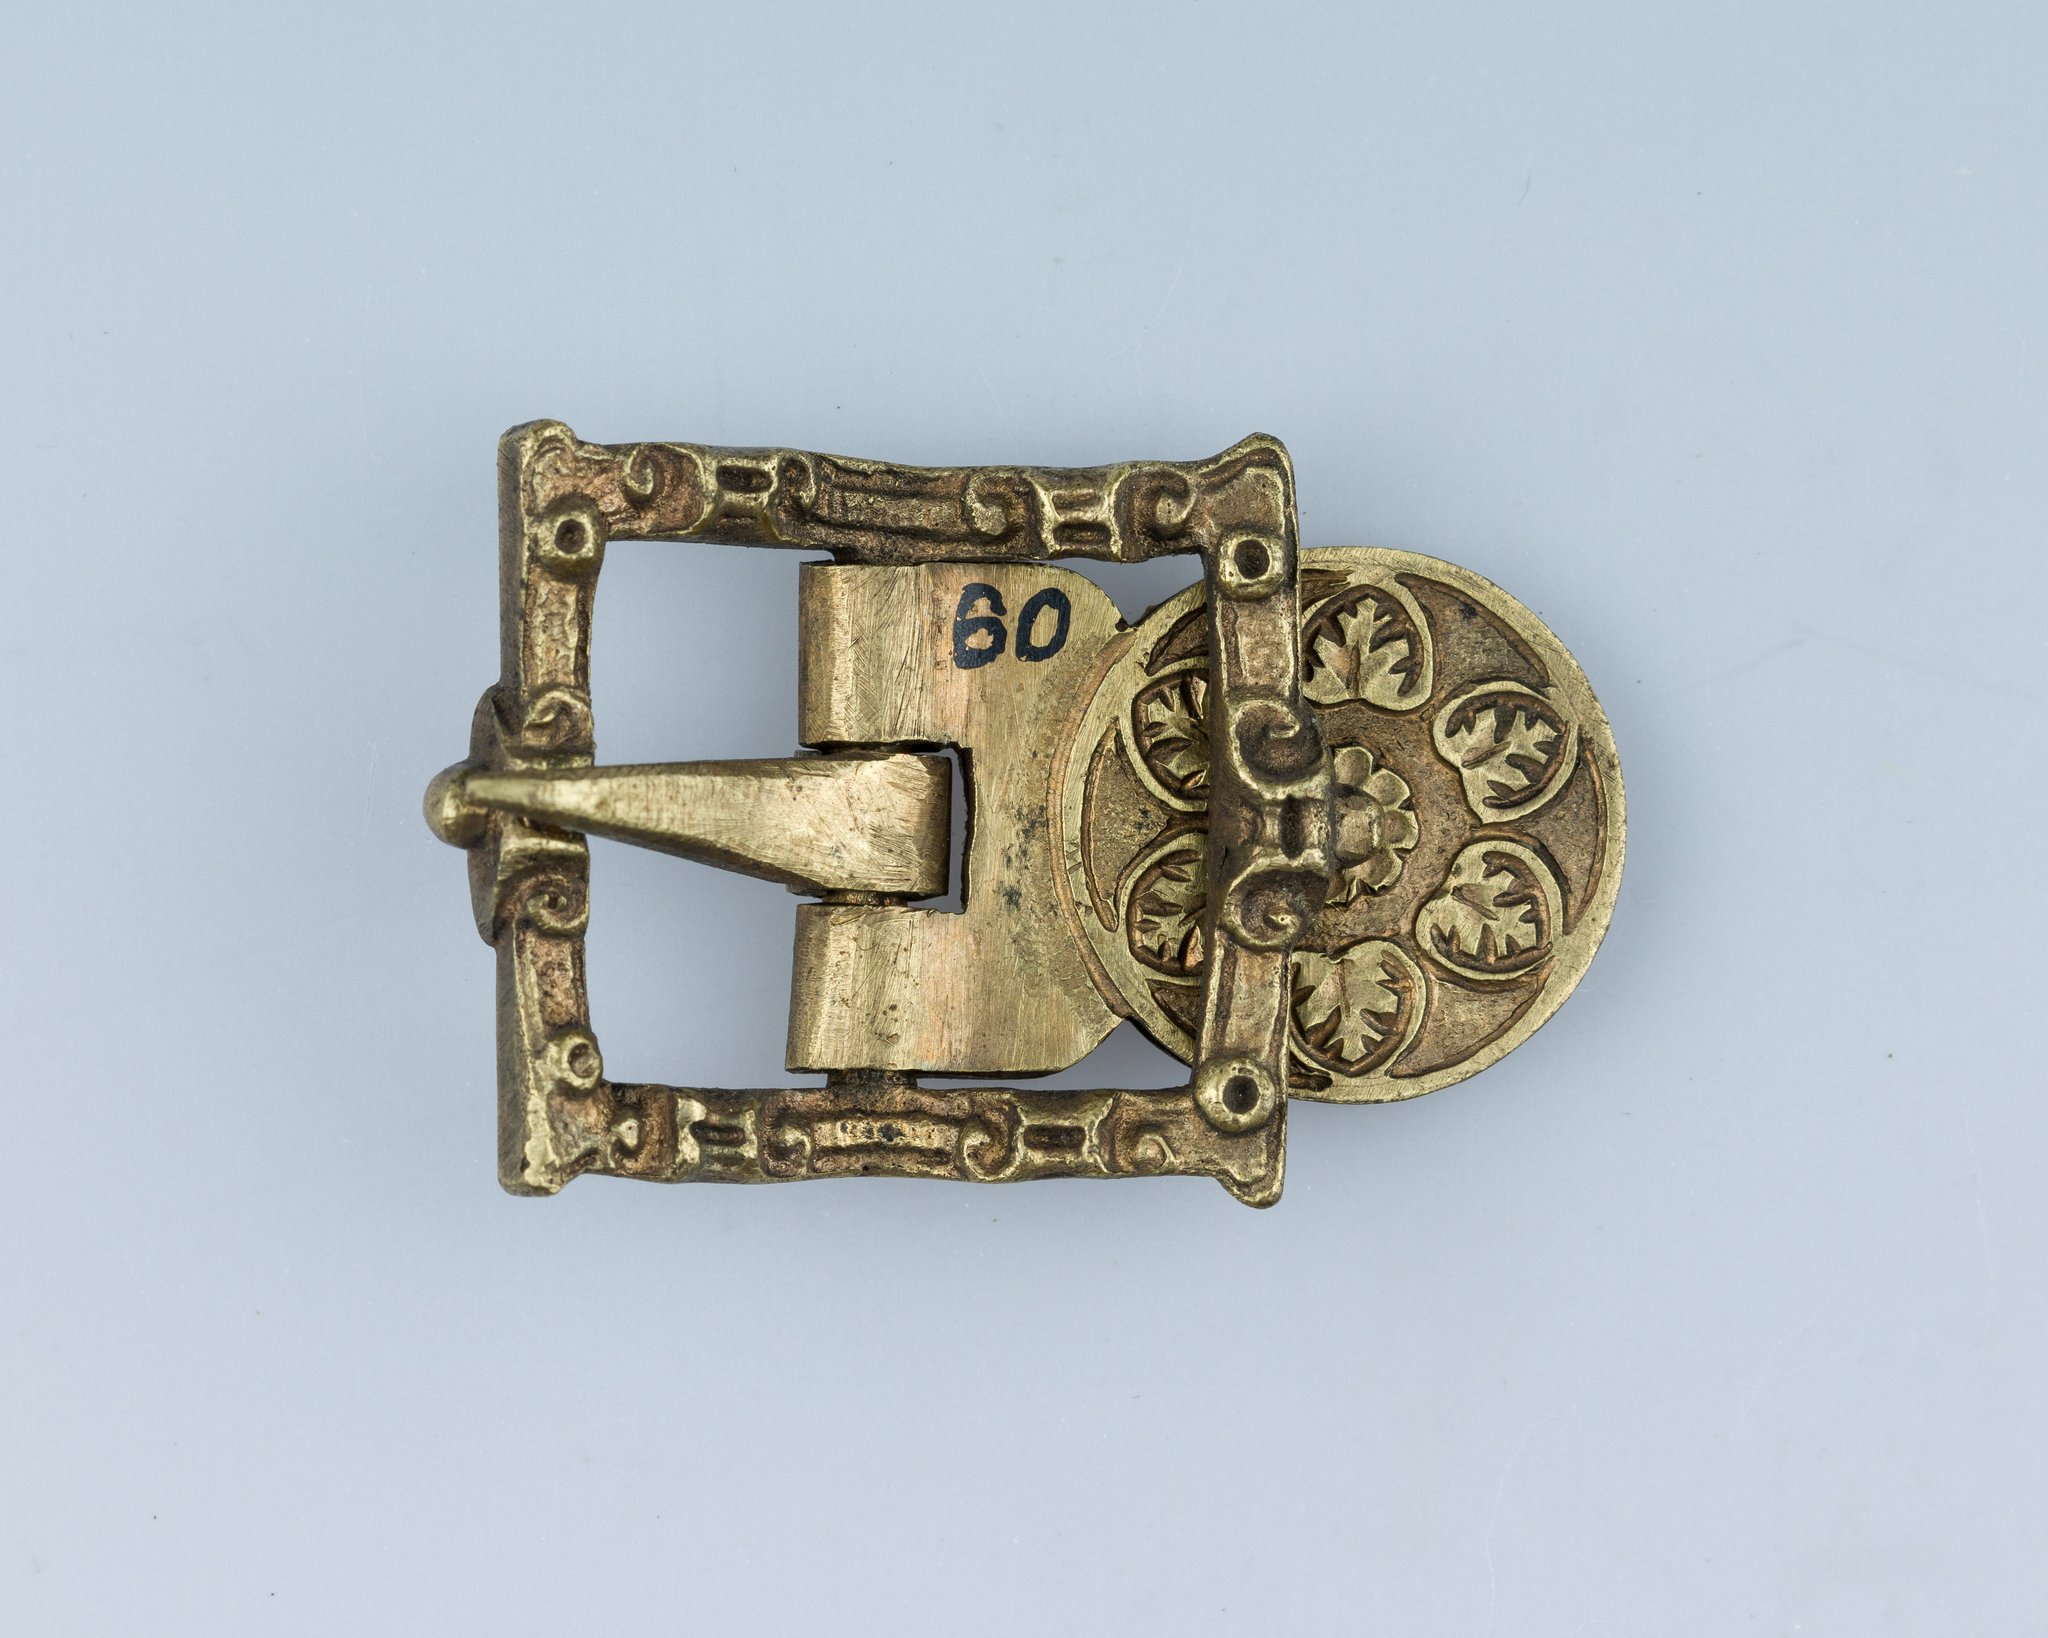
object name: buckle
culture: german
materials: brass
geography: germany